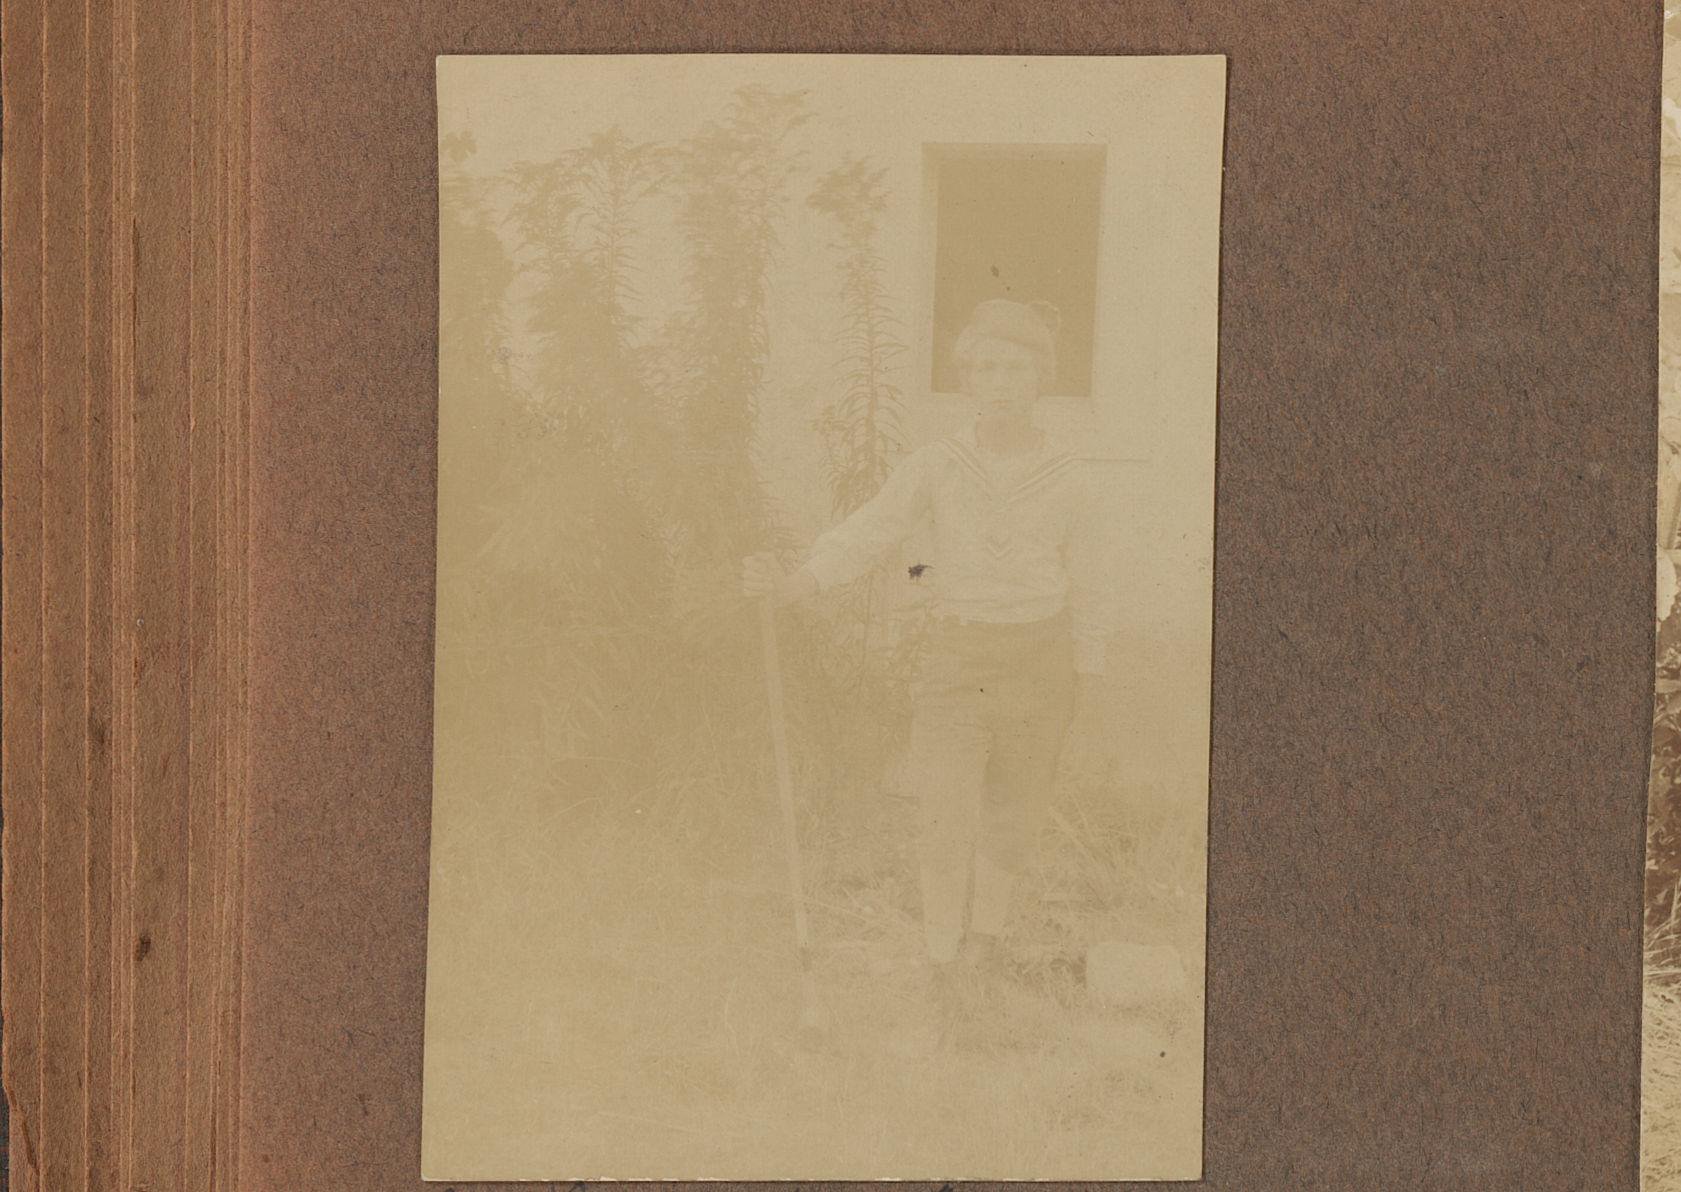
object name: photograph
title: "La Marjolaine" - 1915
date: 1915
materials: photographic support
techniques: photography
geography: netherlands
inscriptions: inscription: ‘"La Marjolaine" - 1915’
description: Foto op bruin albumblad 24 van familiealbum van Alphons Diepenbrock.